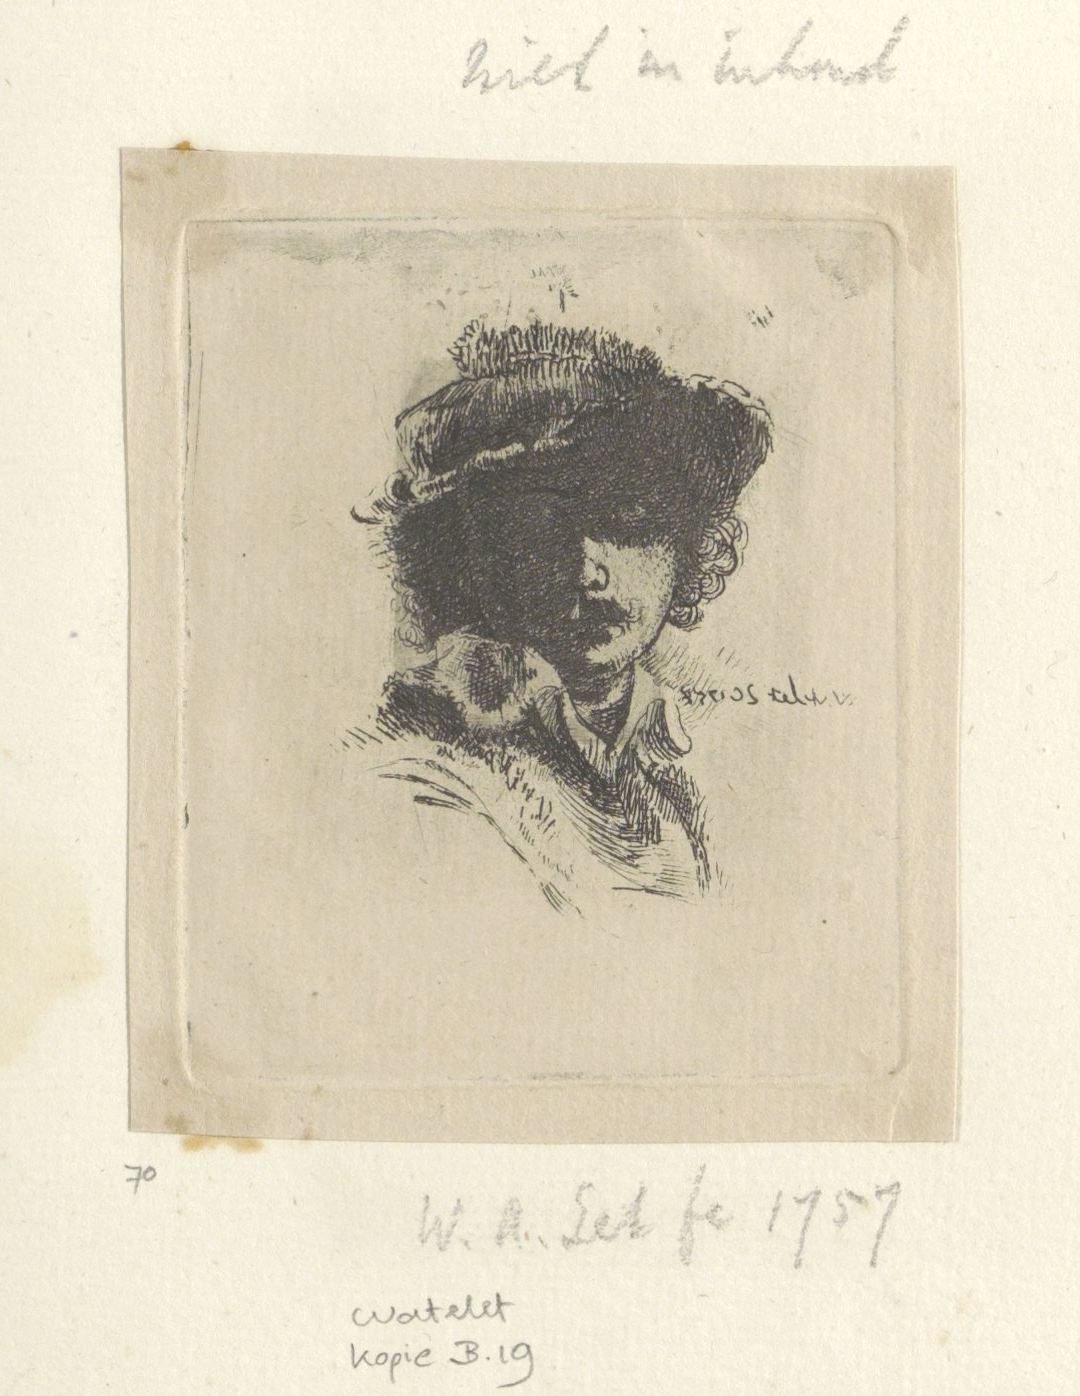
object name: print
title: Recueil de quatre-vingt-cinq estampes originales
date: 1758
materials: paper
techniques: etching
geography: paris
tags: leiden, amsterdam, painter, print maker, draughtsman, rembrandt van rijn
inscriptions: date